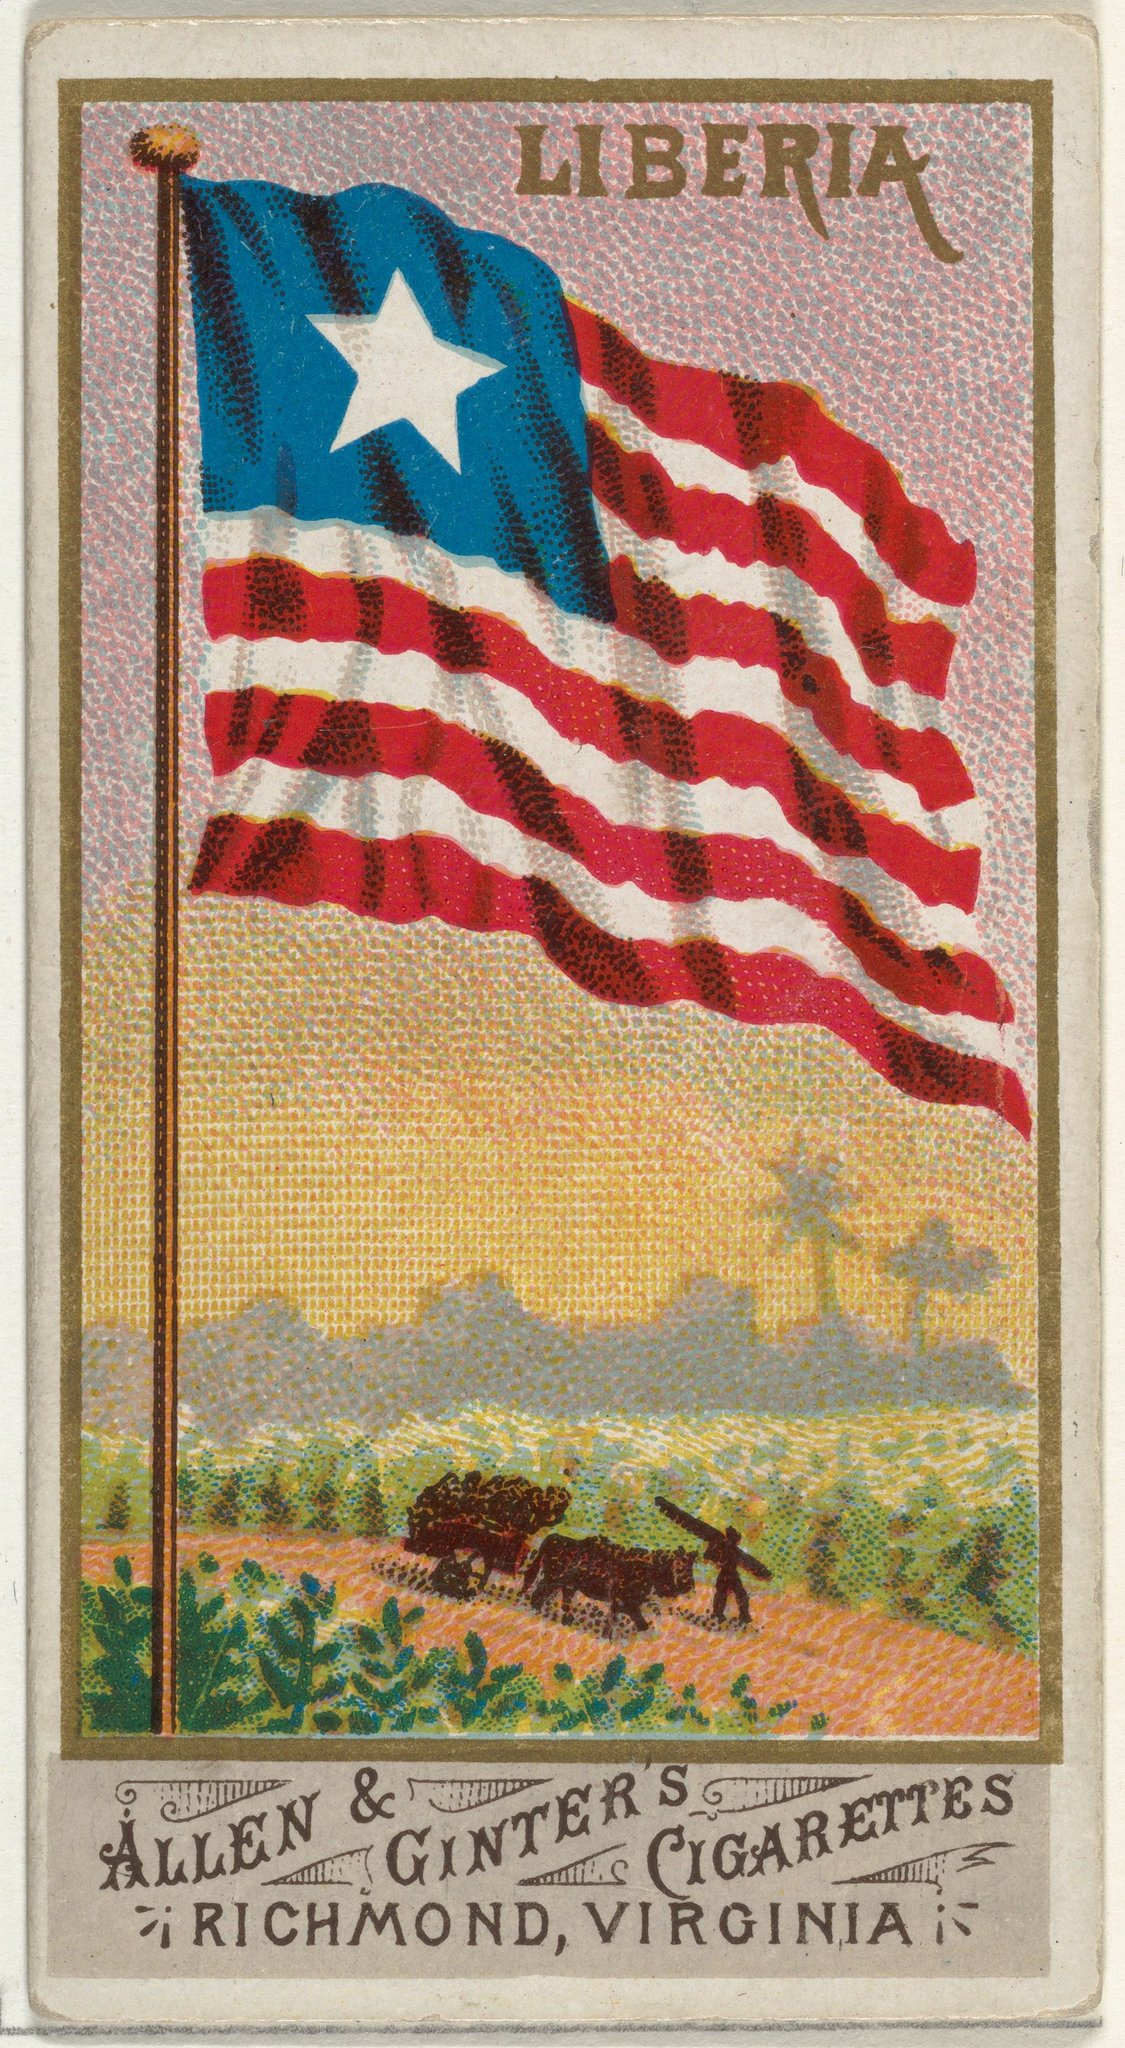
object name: print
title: Liberia, from Flags of All Nations, Series 1 (N9) for Allen & Ginter Cigarettes Brands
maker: allen & ginter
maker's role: publisher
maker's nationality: american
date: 1887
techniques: color lithograph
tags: flags